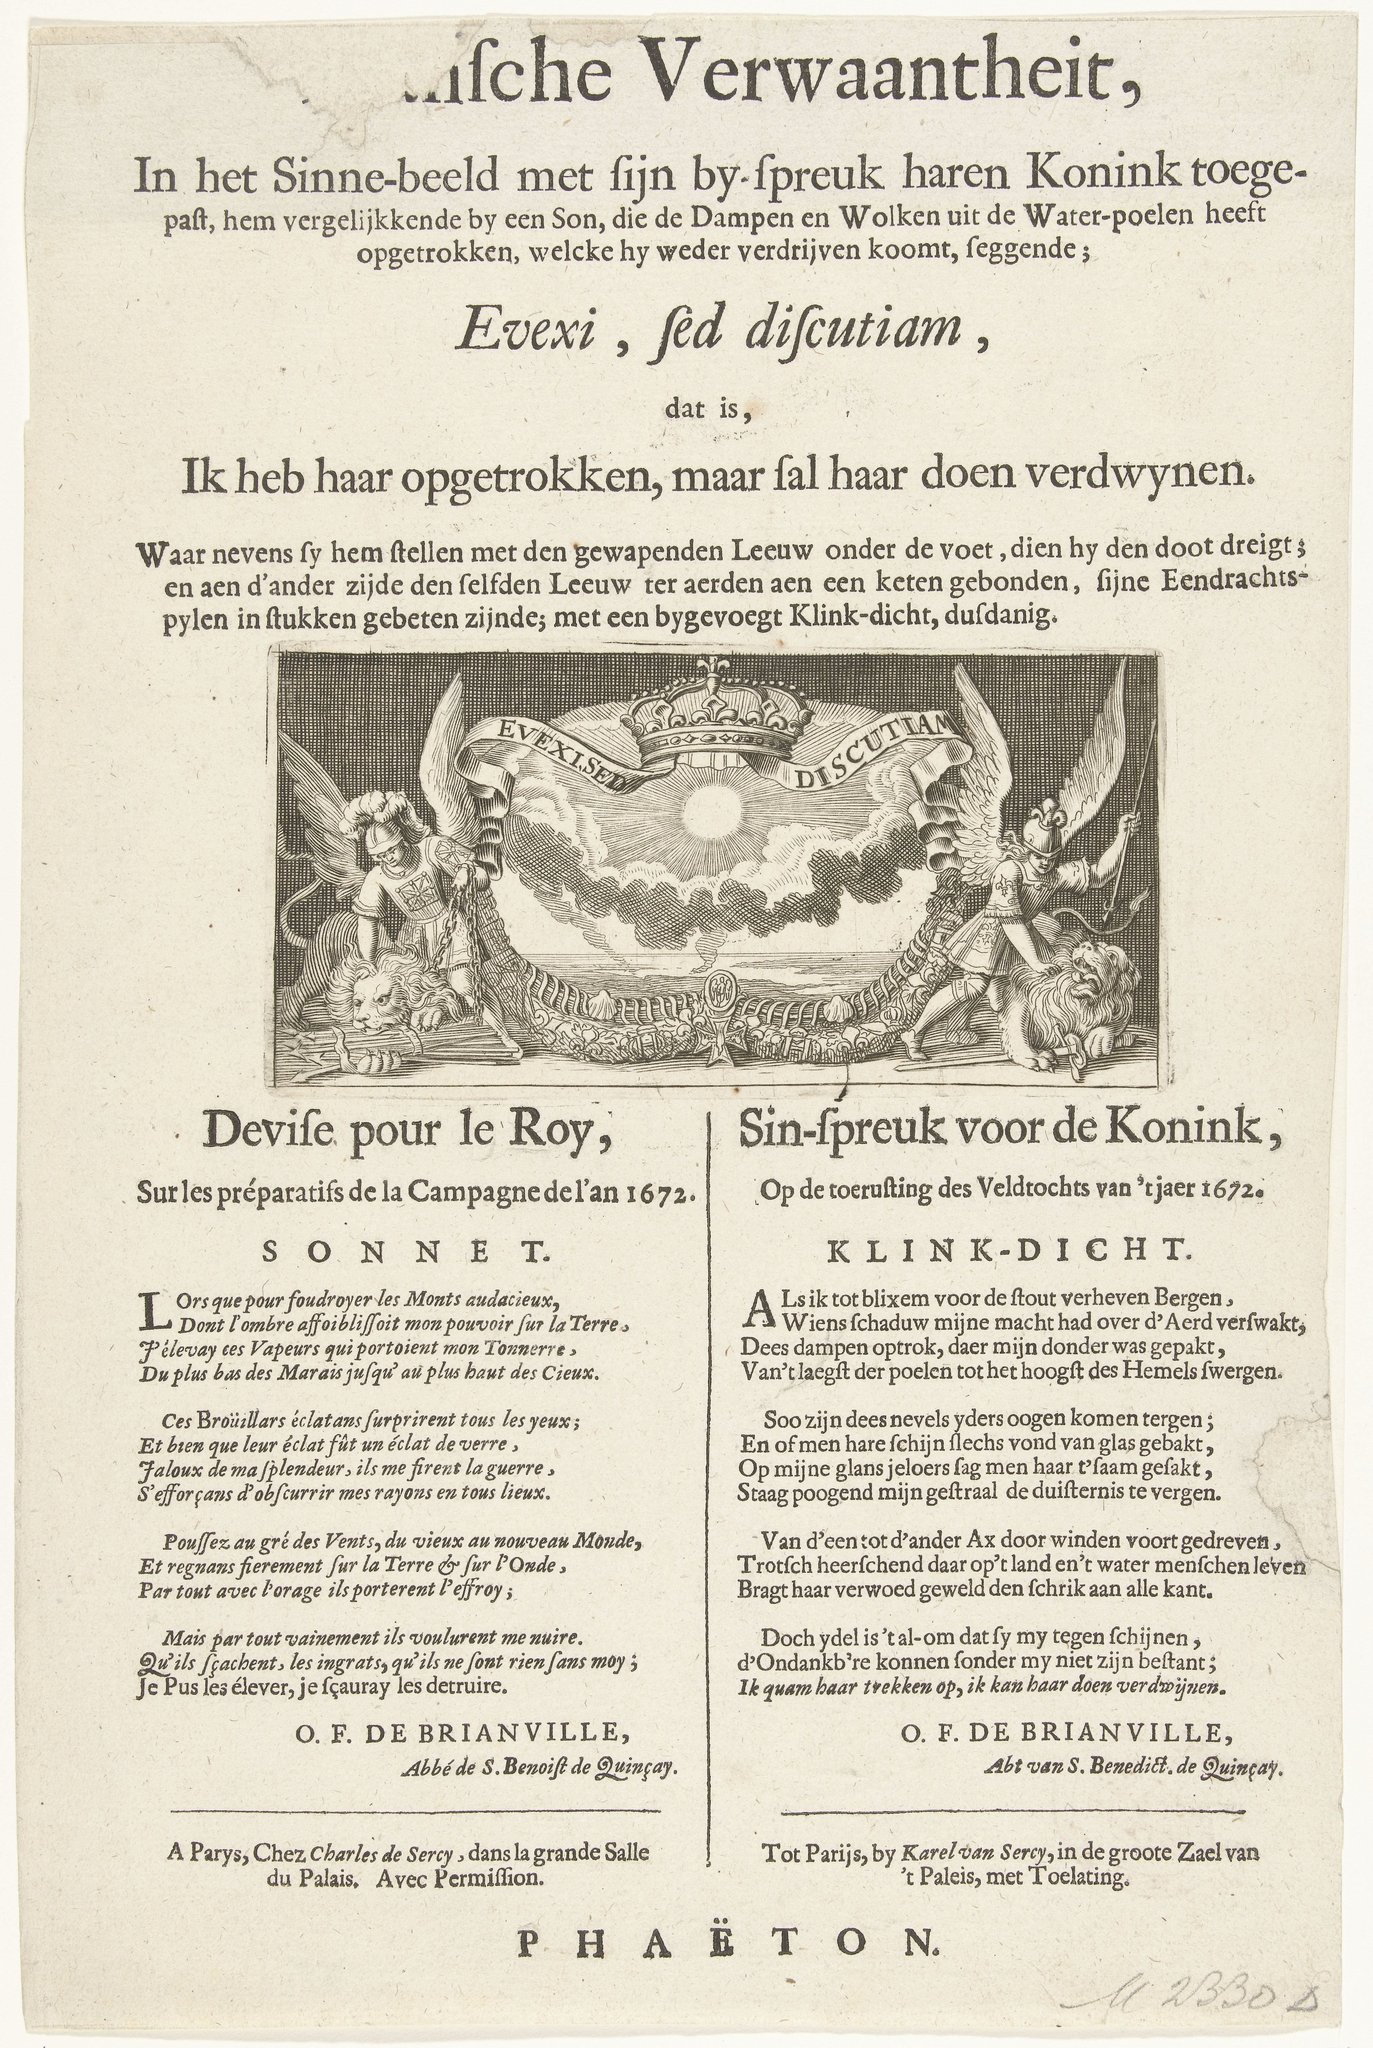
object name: print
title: Franse allegorie waarin Lodewijk XIV zich vergelijkt met de zon, 1672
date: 1672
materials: paper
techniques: engraving, letterpress printing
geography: northern netherlands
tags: lodewijk xiv (koning van frankrijk), sun as celestial body, rampjaar (disaster year)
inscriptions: collector's mark: Lugt 240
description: Nederlandse versie van een oorspronkelijk Frans blad waarin de oorlog met de Nederlanden wordt gerechtvaardigd. Met een verklaring van het zinnebeeld van de Franse koning, waarin hij zich vergelijkt met de zon en waarin de Nederlandse Leeuw overwonnen wordt (FMH nr. 2331A). Onder de voorstelling het Franse vers, en de Nederlandse vertaling, op de voorbereidingen die de Fransen treffen voor de veldtocht in 1672. Het blad is ondertekend met de naam 'Phaëton'. Het oorspronkelijke Franse embleem is vervaardigd door Sebastien le Clerc.